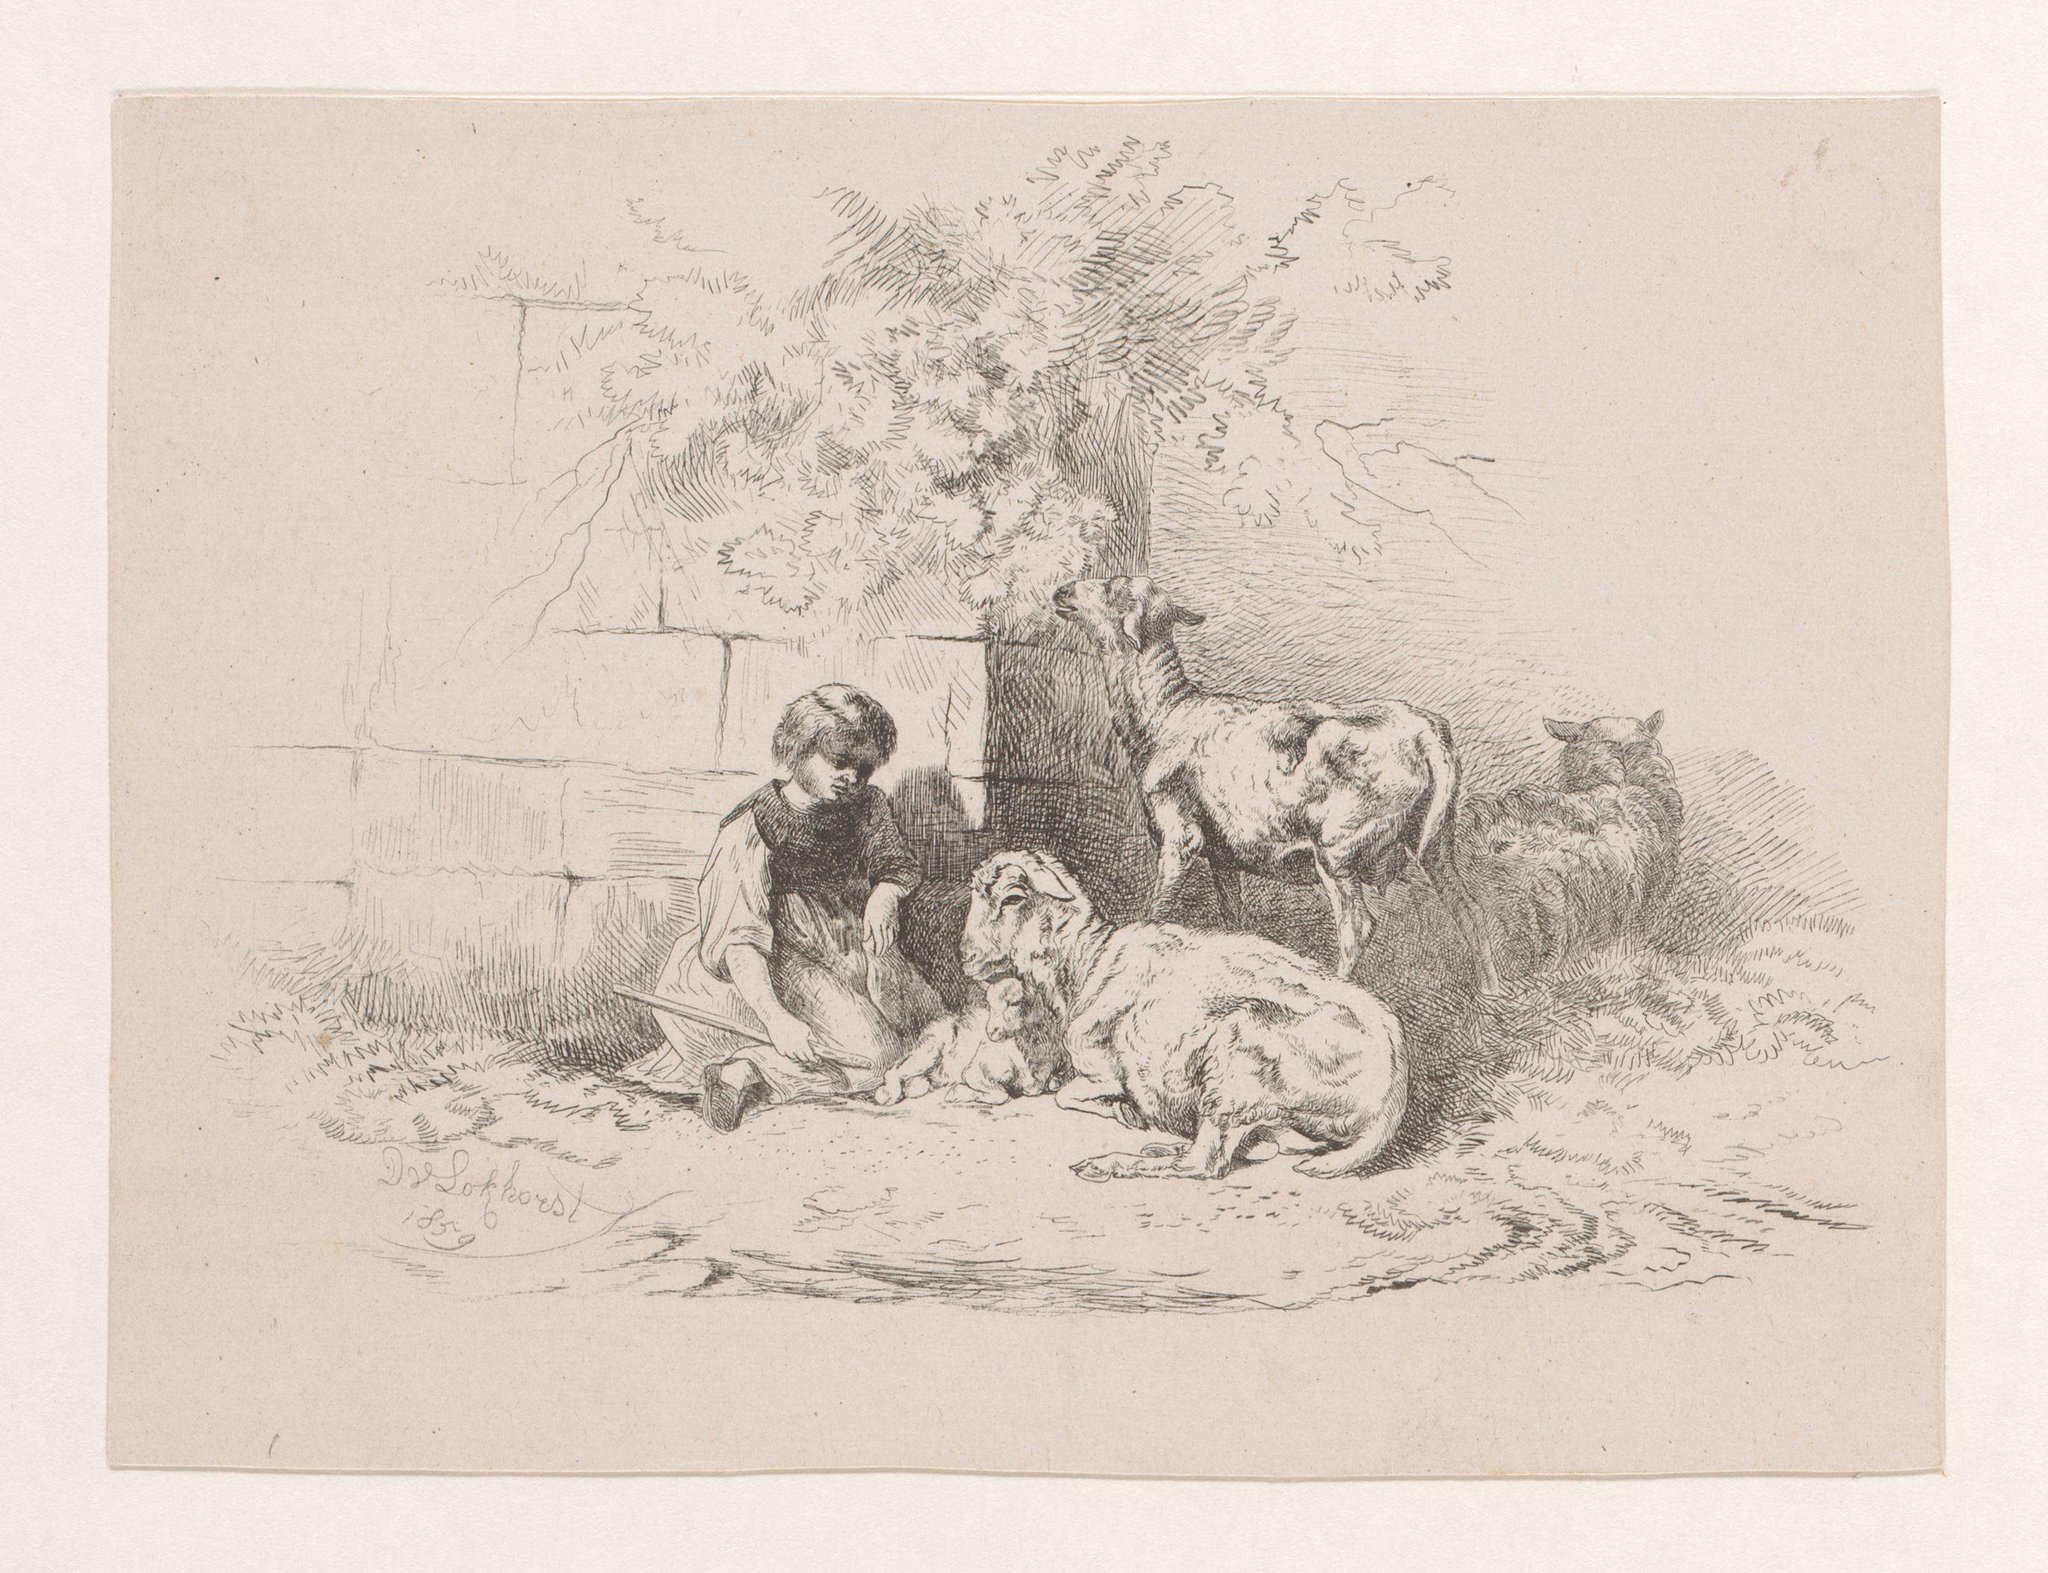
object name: print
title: Meisje bij schapen en lam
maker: dirk van lokhorst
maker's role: draughtsman, painter, print maker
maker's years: 1818-1893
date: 1859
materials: paper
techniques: lithograph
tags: adolescent, young woman, maiden, lamb, sheep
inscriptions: collector's mark: Lugt 2228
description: Het meisje zit geknield voor een muur bij het lam. Daarachter een geschoren en ongeschoren schaap.